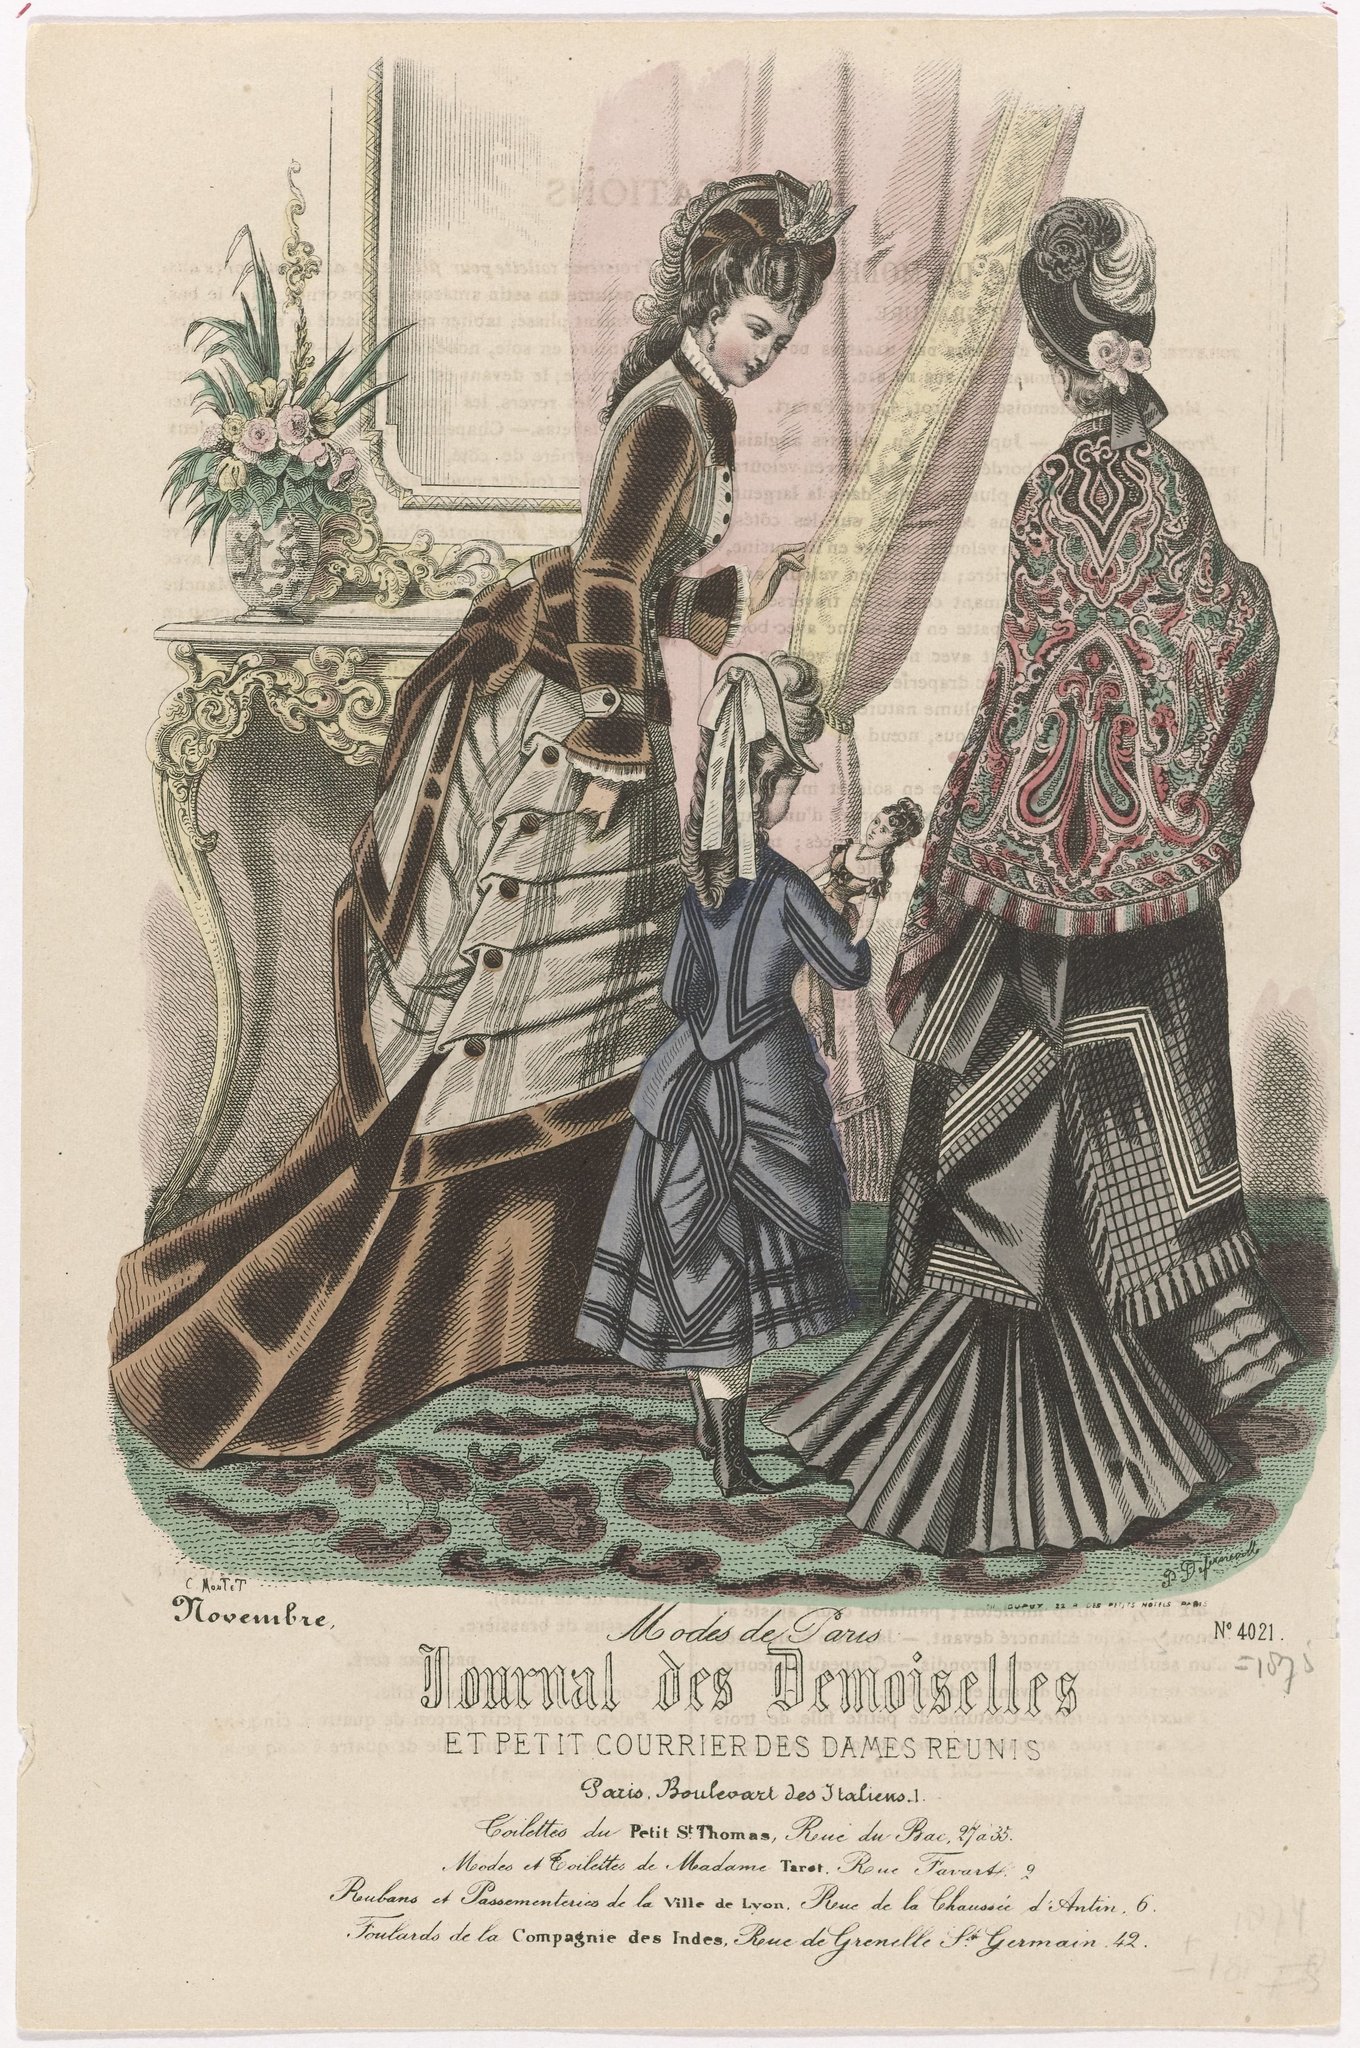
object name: fashion print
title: Journal des Demoiselles, Novembre 1875, No. 4021 : Toilettes du Petit St. Thomas (...)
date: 1875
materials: paper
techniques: engraving, hand coloring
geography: paris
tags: clothing for the upper part of the body (shawl) (+ women's clothes), head-gear (+ girls' clothes), boots (+ girls' clothes), fashion plates, head-gear: hat (+ women's clothes), skirt (+ women's clothes), (playing with) dolls, head-gear: hat (+ feathers used for clothes)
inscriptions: title: ‘Modes de Paris / Journal des Demoiselles / et Petit Courrier des Dames Réunis’, caption: ‘Toilettes du Petit St Thomas, Rue du Bac, 27 a 35 Modes et Toilettes de Madame Tarot, Rue Favart, 2 Rubans et Passementeries de la Ville de Lyon. Rue de la Chaussée d'Antin6. Foulards de la Compagnie des Indes, Rue de Grenelle St Germain 42.’, address: ‘Paris, Boulevart des Italiens,1.’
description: twee vrouwen en kind in interieur, gekleed in japonnen van Petit St Thomas en van Madame Tarot. Linten en passement van Ville de Lyon. Stoffen van Compagnie des Indes. Prent uit het modetijdschrift Journal des Demoiselles (1833 -1922).